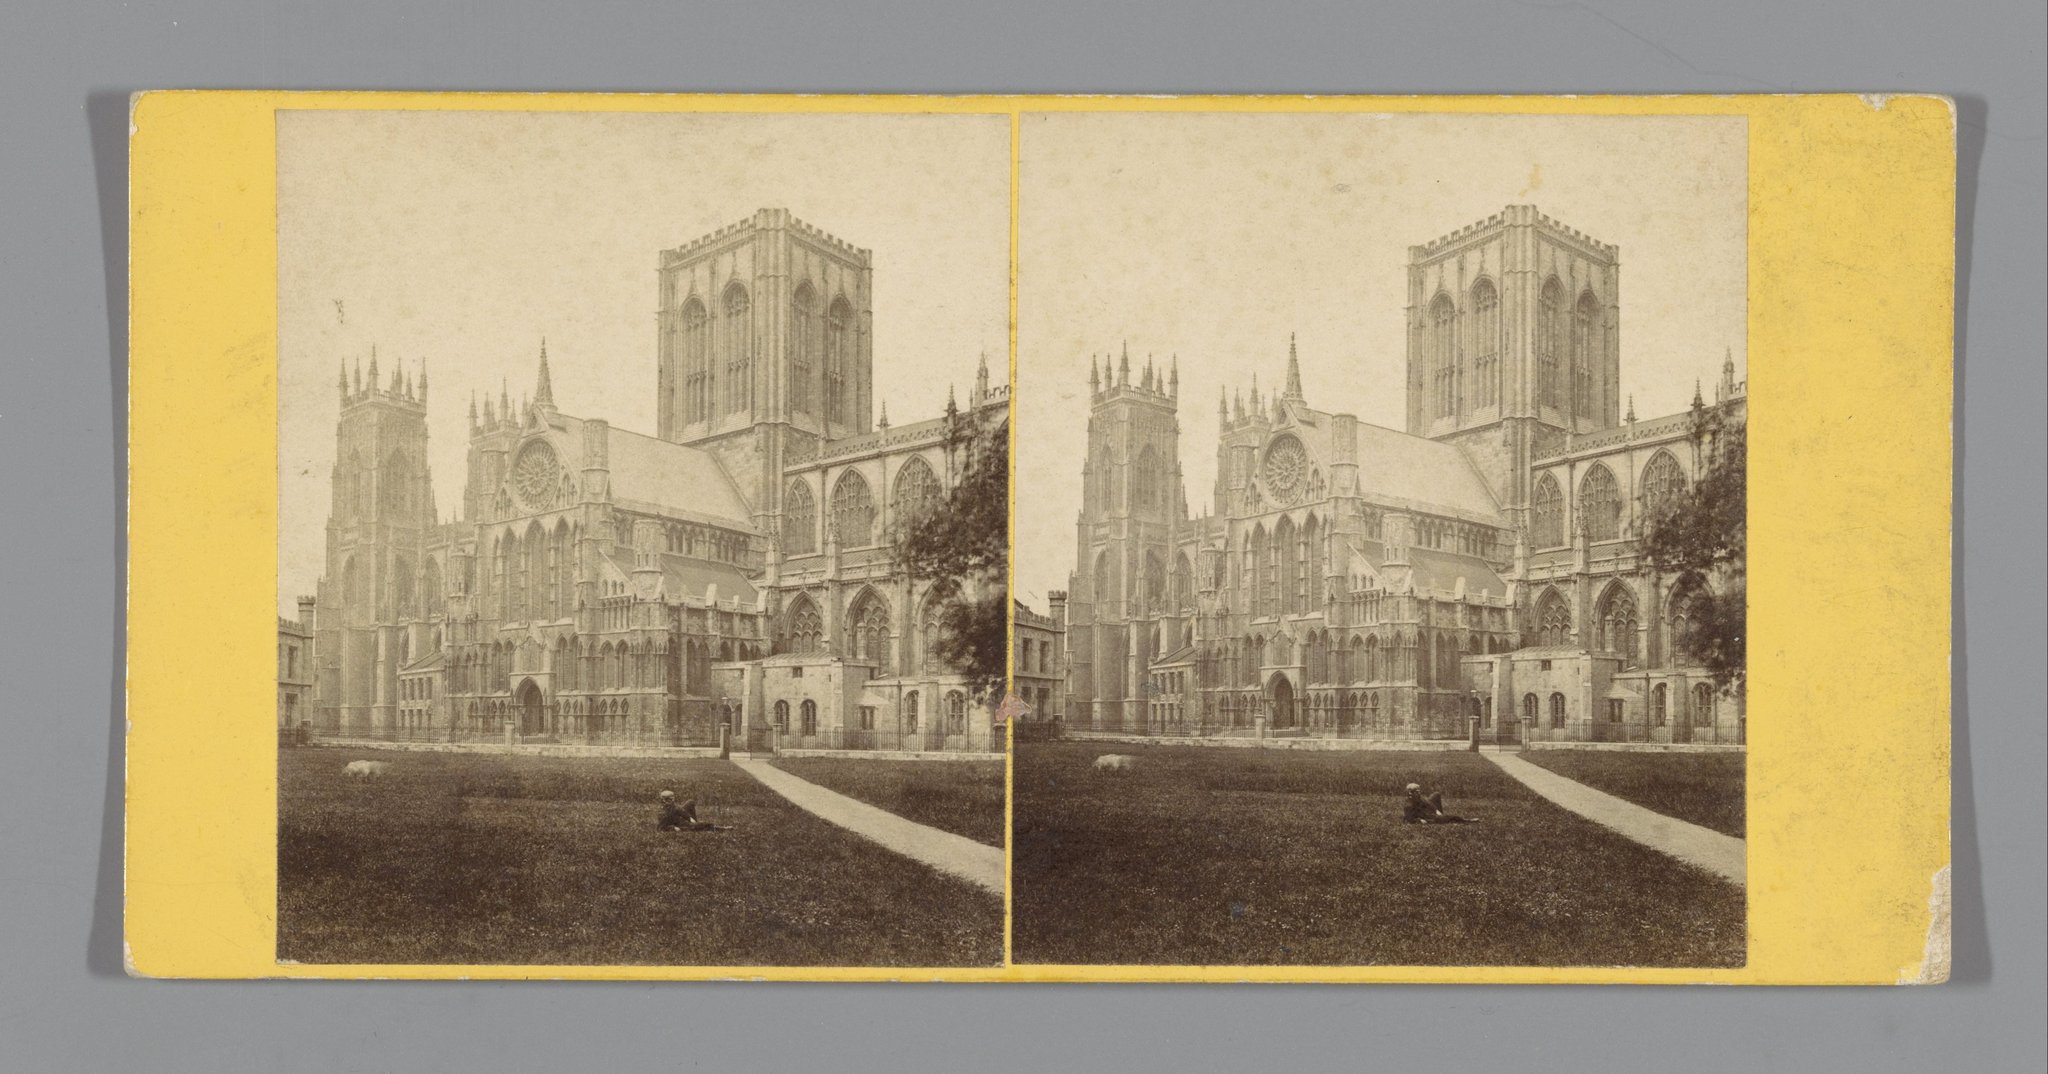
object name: stereograph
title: Exterieur van de Kathedraal van York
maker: george washington wilson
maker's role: publisher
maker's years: 1823-1893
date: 1850-1880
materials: cardboard, photographic support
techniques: albumen print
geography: york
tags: church (exterior), façade (of house or building)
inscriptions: number: ‘No. 372.’, name: ‘G. W. Wilson, Photographer, Aberdeen.’